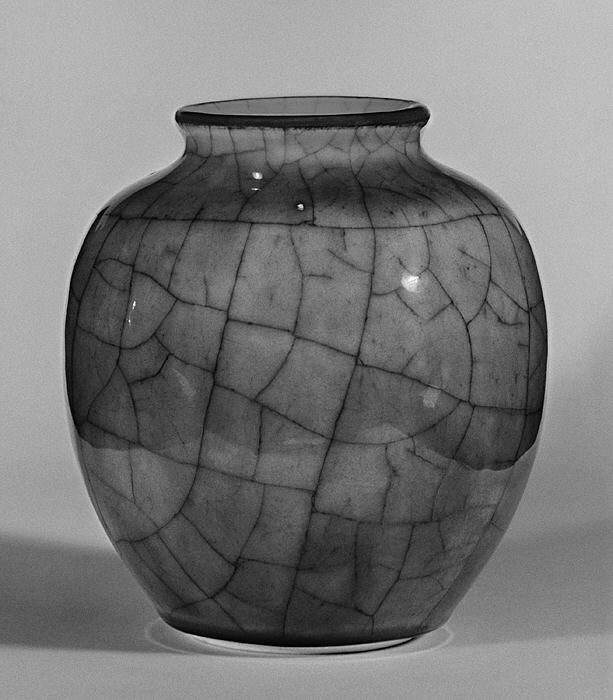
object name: jar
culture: chinese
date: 1701-1800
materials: glaze, porcelain